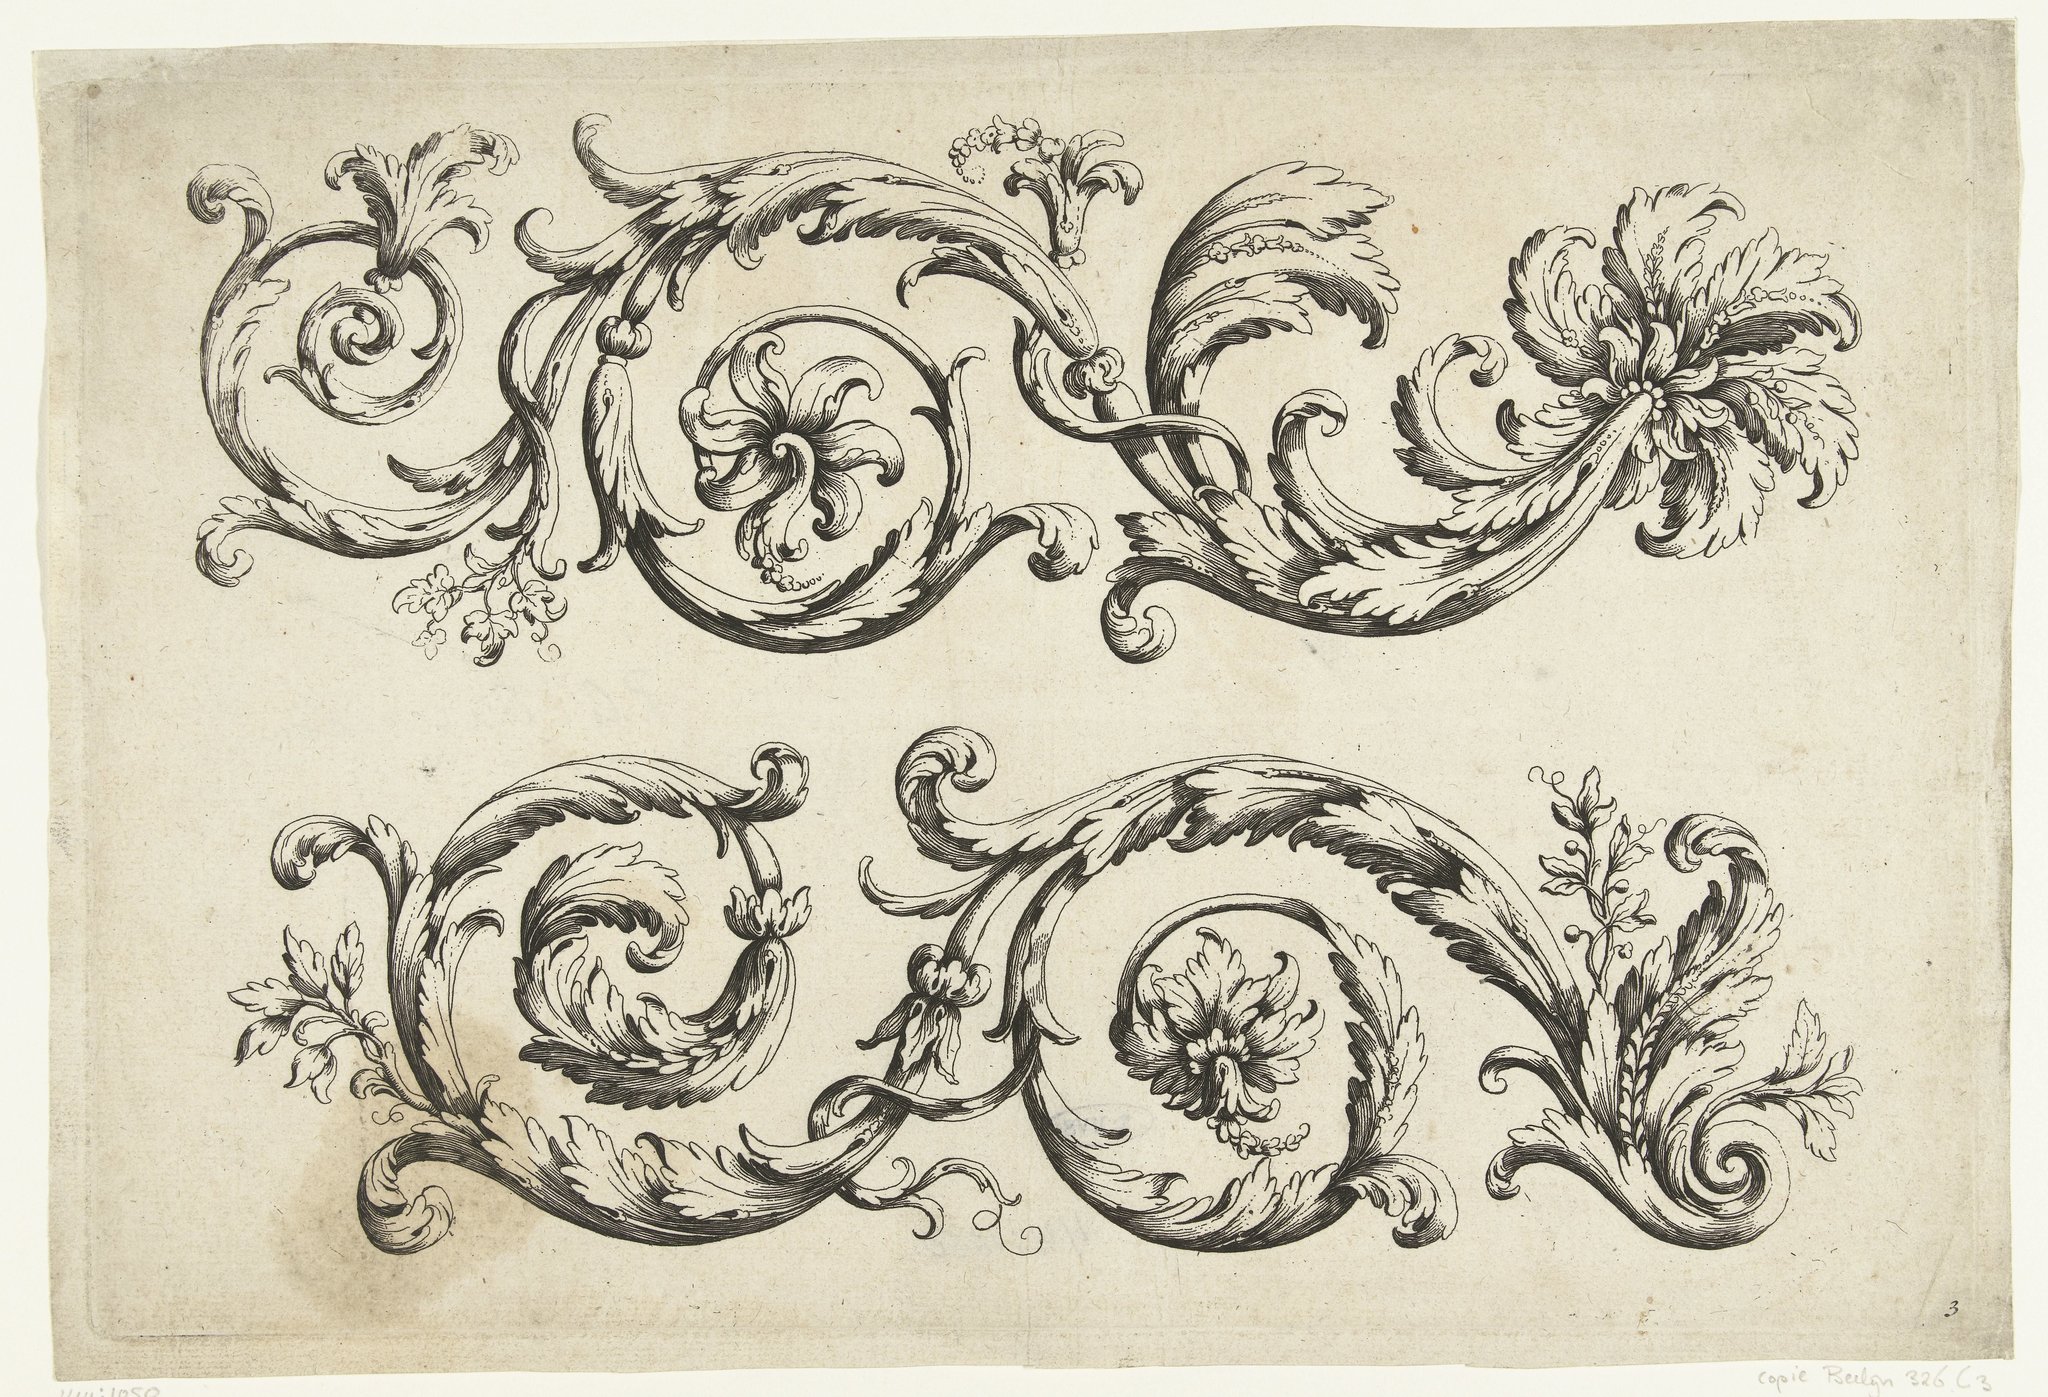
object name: ornament print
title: Twee friezen van bladranken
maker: Anonymous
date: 1640-1760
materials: paper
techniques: etching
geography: france